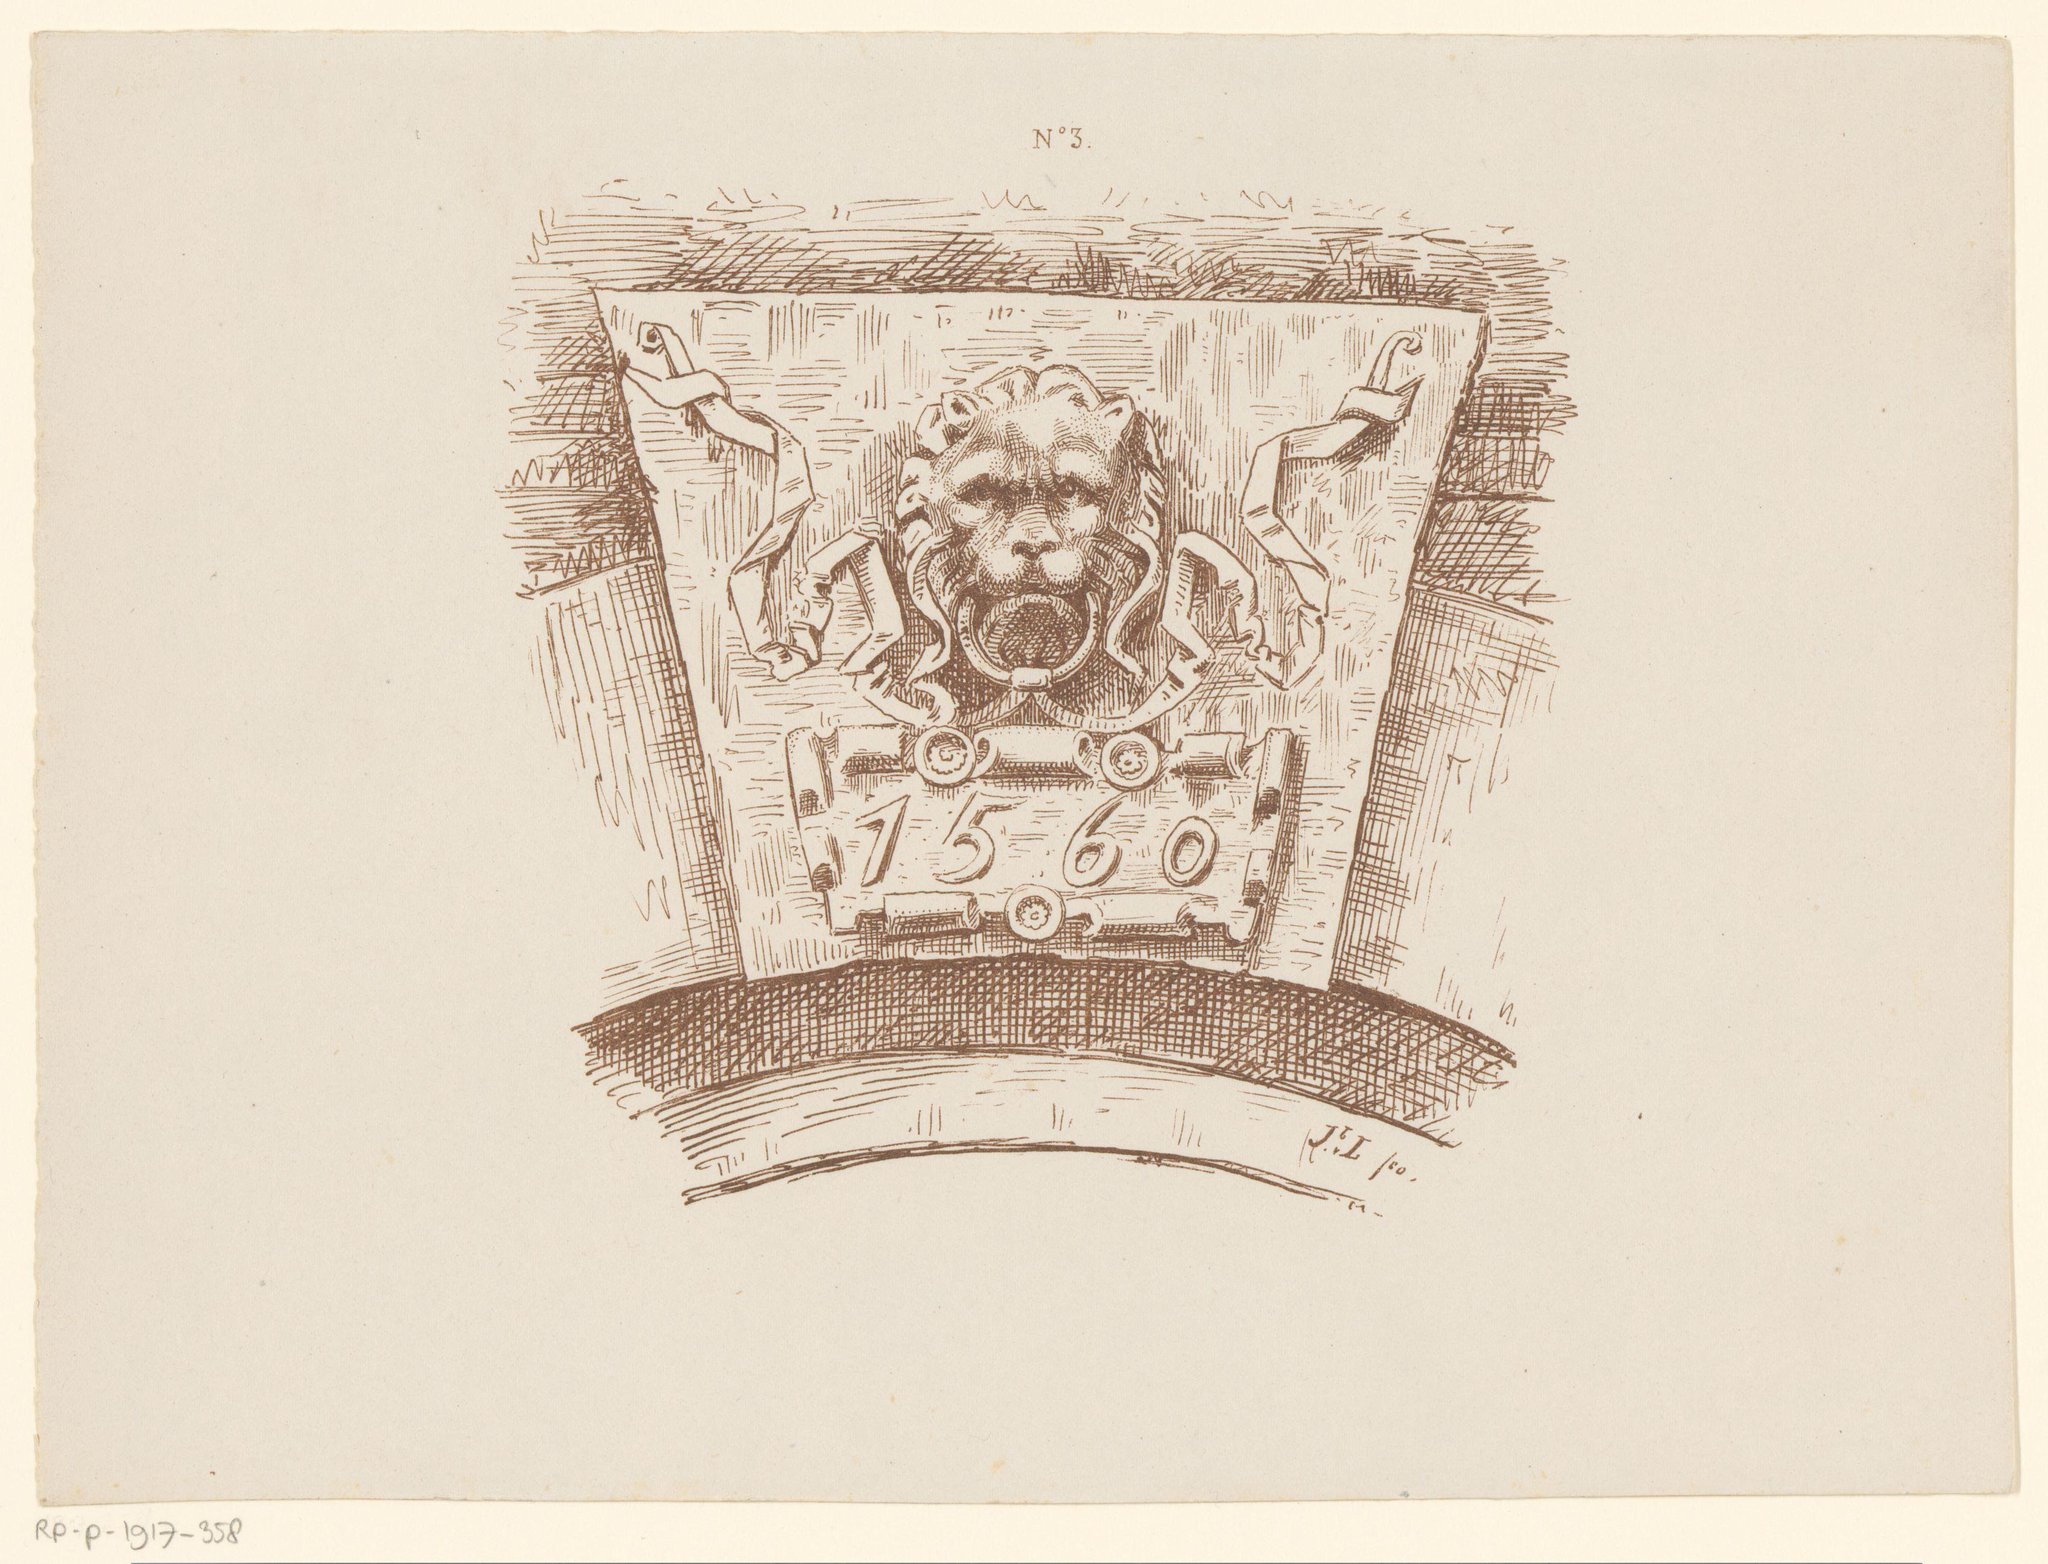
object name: print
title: Sluitsteen met het jaartal 1560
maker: jac van looij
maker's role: draughtsman, painter, print maker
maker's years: 1855-1930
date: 1877-1894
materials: paper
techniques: lithograph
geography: amsterdam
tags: lion's head ~ ornament, keystone ~ architecture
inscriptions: collector's mark: Lugt 2228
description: Mogelijk uit het Begijnhof in Amsterdam. Boven het jaartal een leeuwenkop. Genummerd midden boven: No. 3.